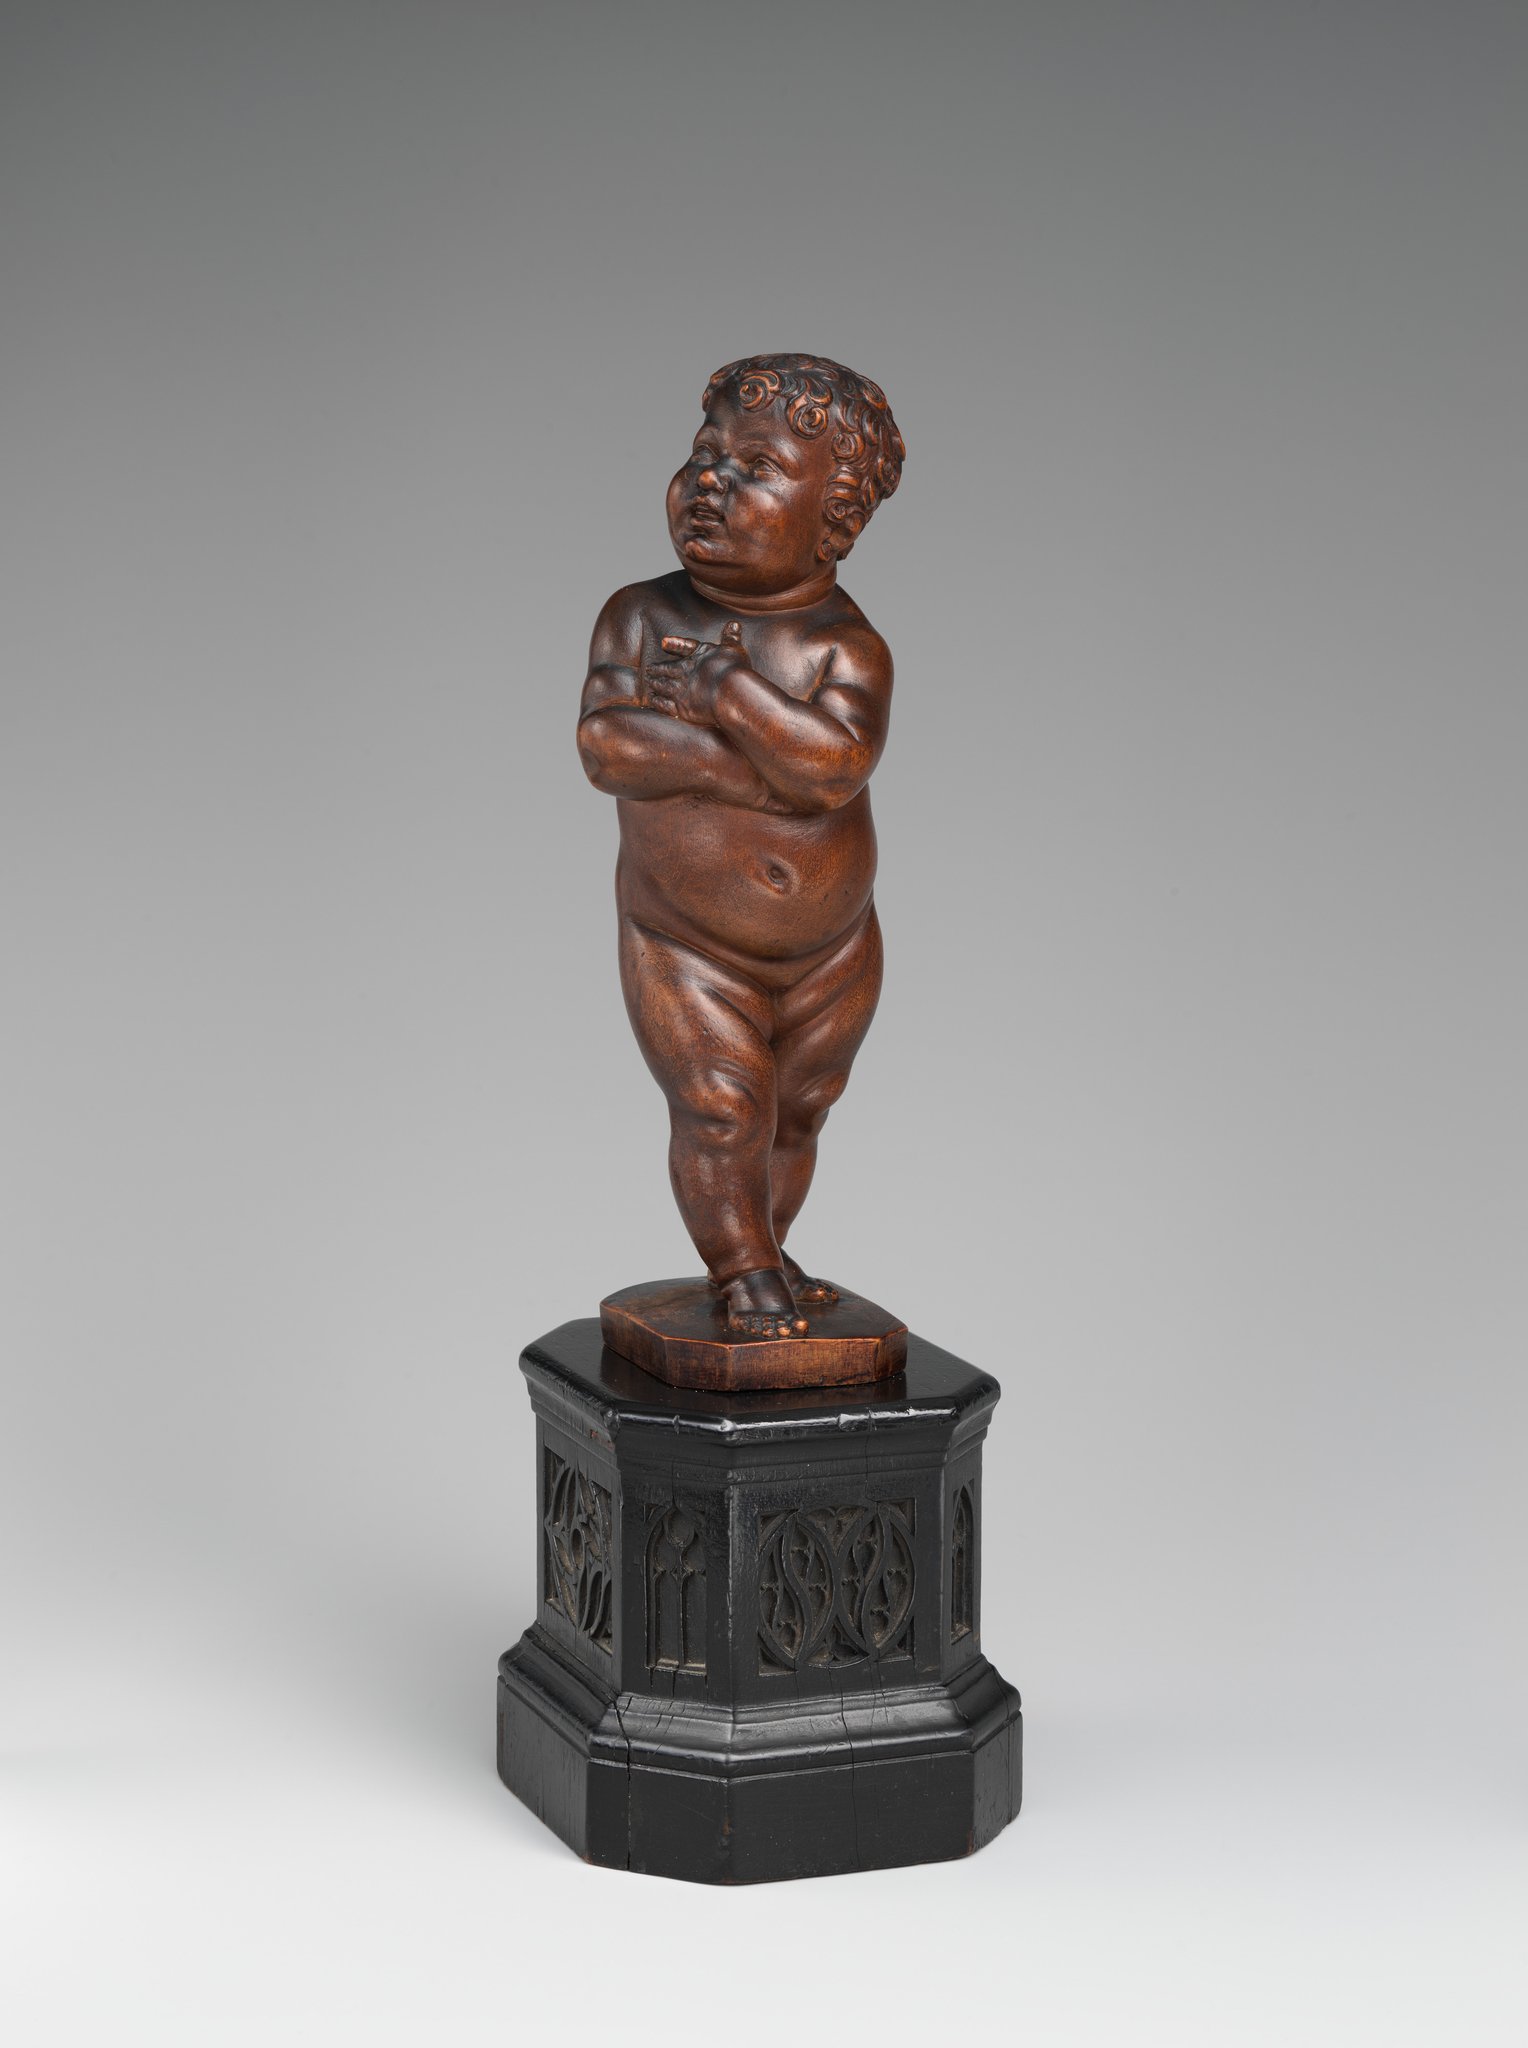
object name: statuette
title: Girl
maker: leonhard kern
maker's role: artist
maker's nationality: german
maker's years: 1588-1662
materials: wood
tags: girls